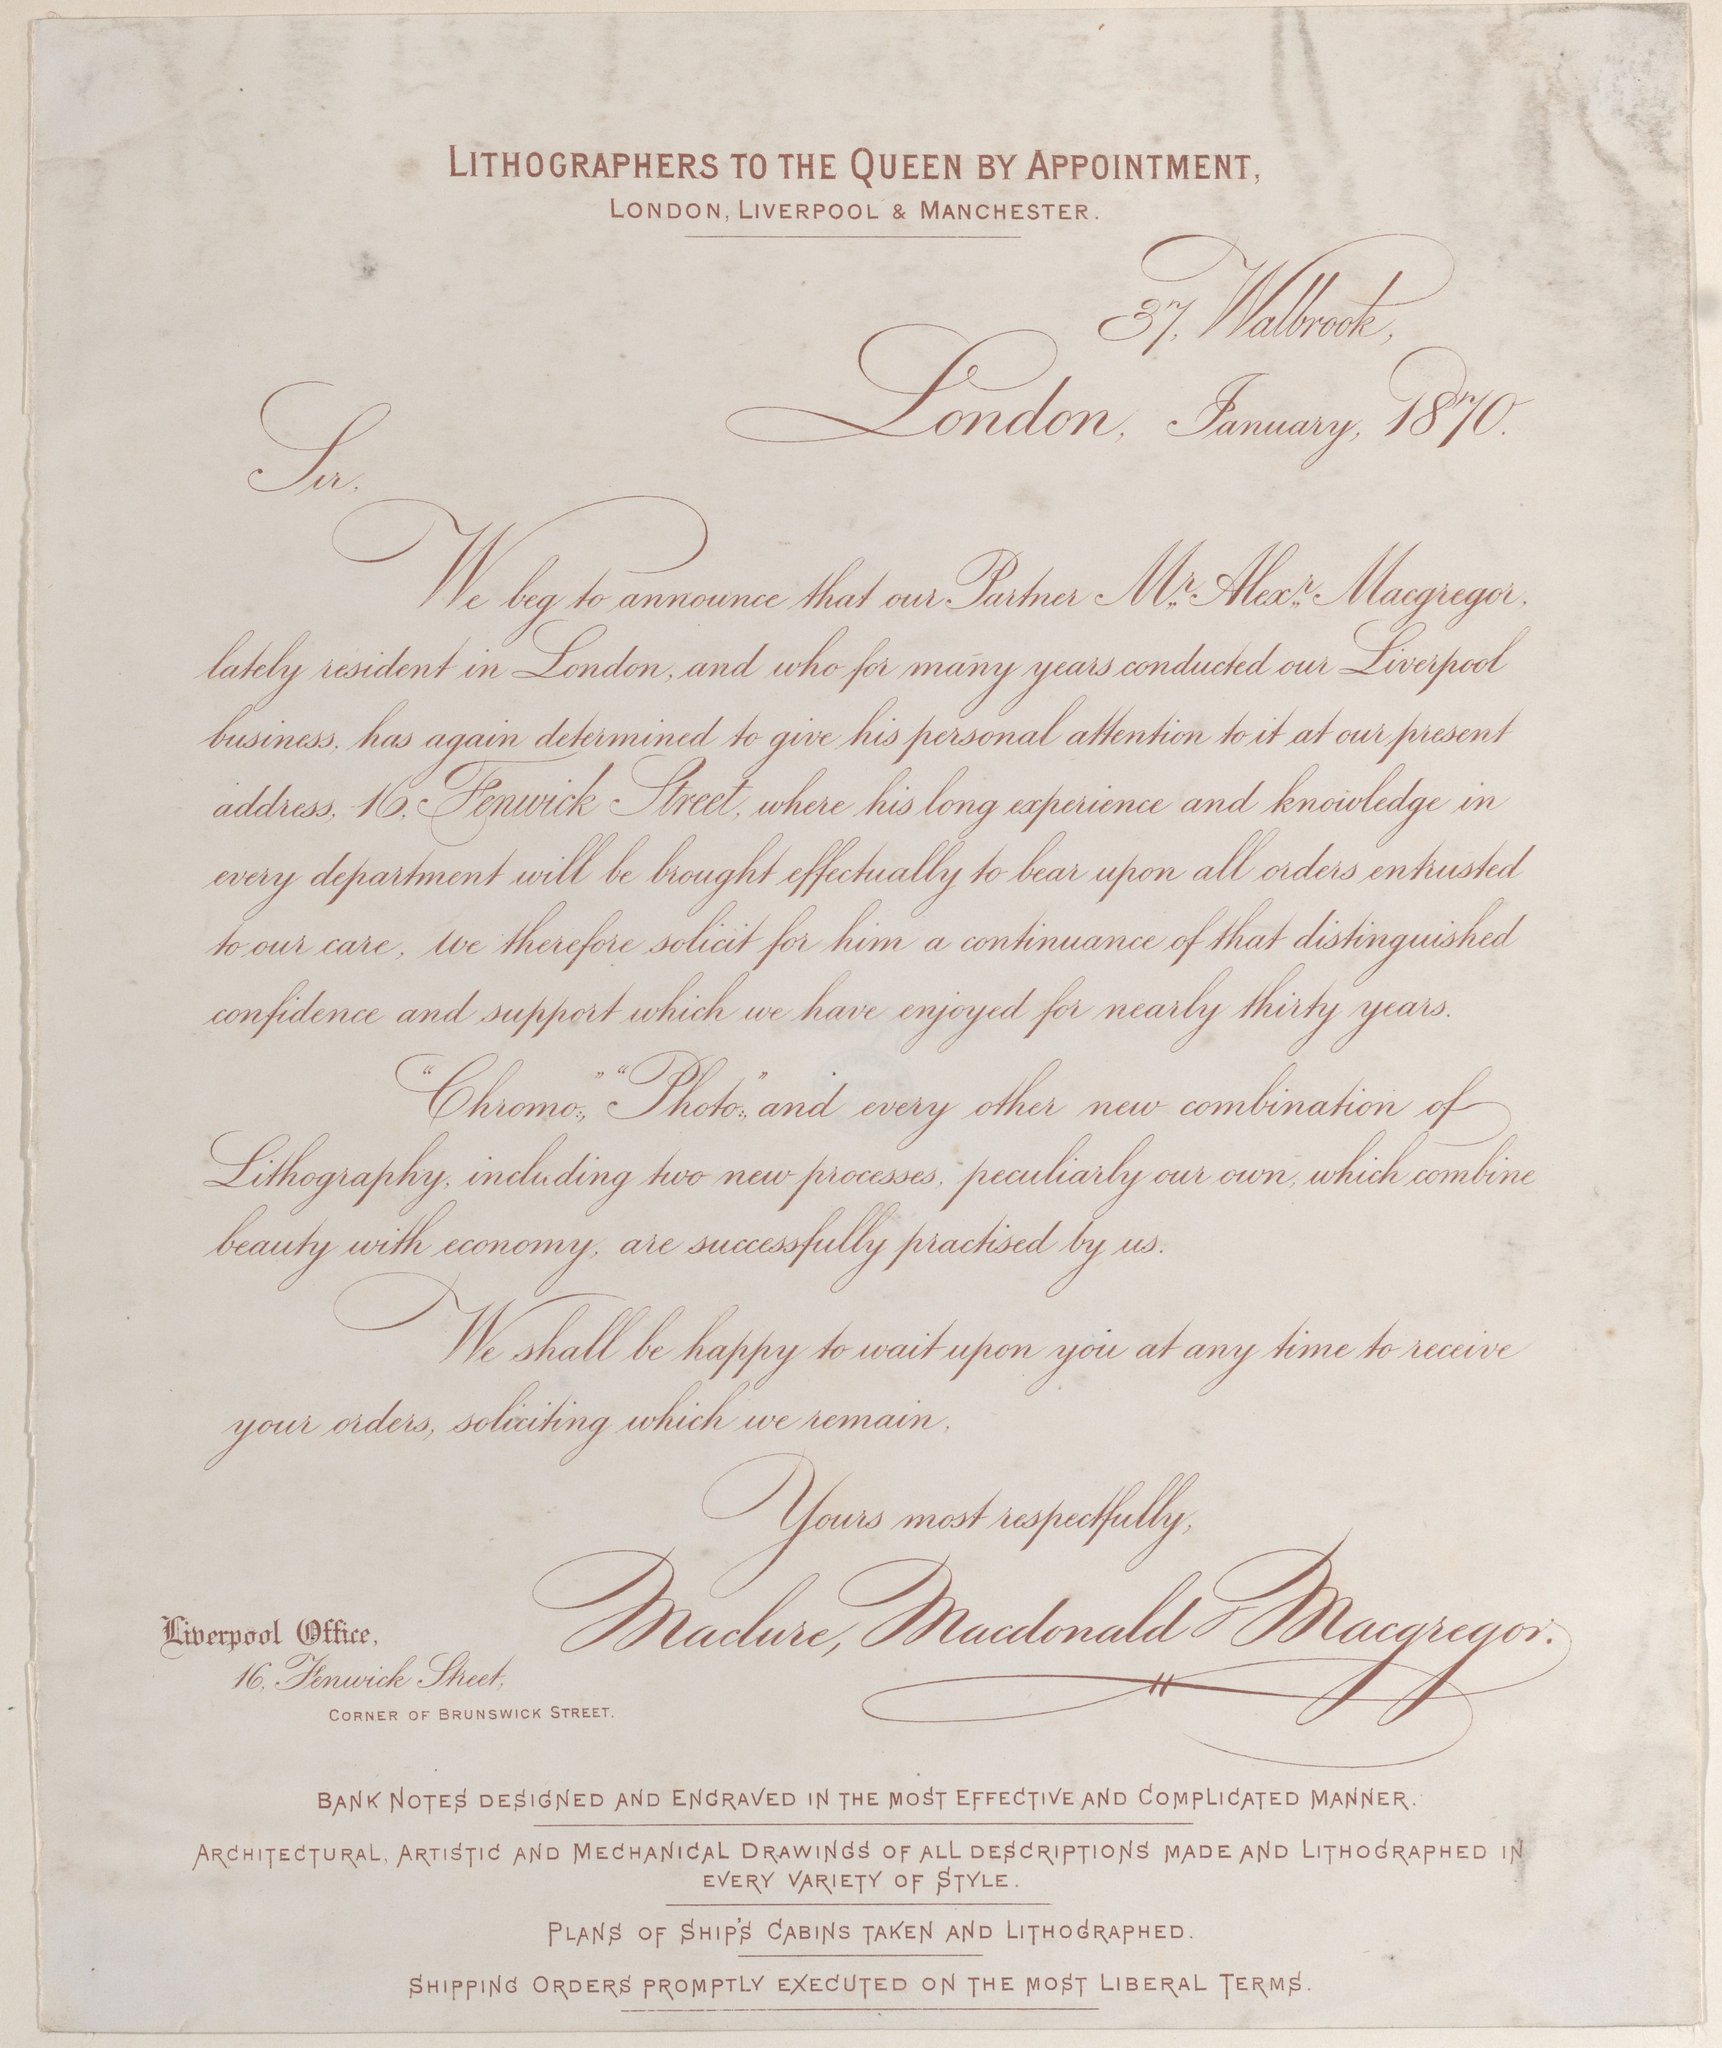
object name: print, trade card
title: Trade card for Maclure, Macdonald & Macgregor, publisher and printer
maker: anonymous, british, 19th century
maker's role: artist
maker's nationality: british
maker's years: 1800-1900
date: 1801-1900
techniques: lithography